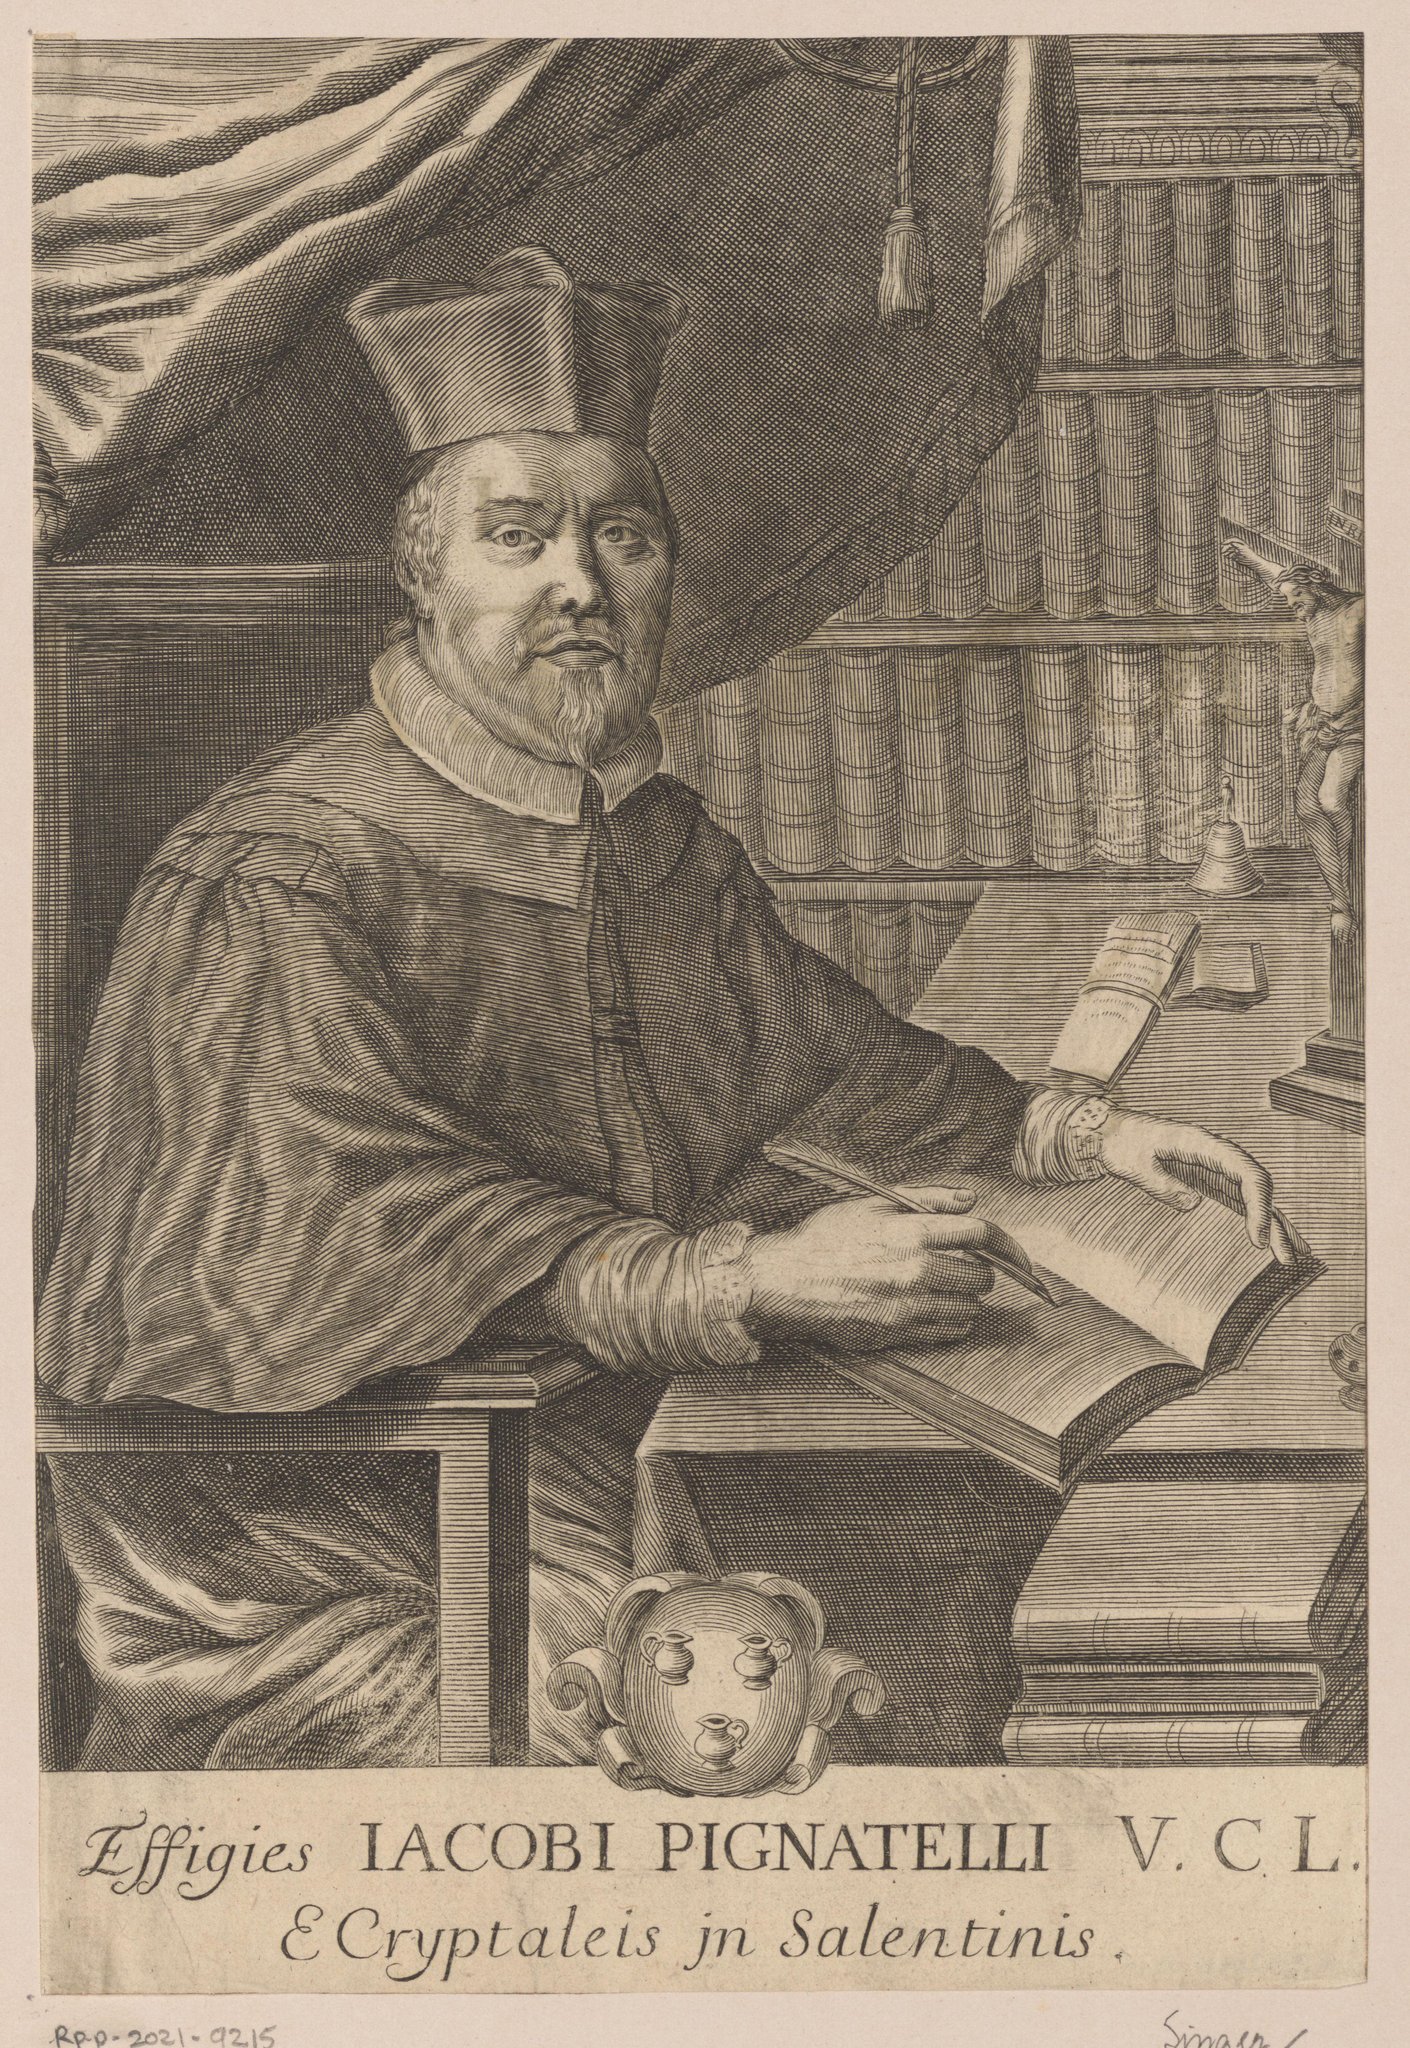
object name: book illustration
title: Portret van Jacob Pignatelli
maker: Anonymous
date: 1700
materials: paper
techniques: engraving, letterpress printing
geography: lyon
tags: adult man, historical persons, printed matter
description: Prent uit: Pignatelli, Jacobus. Consultationes canonicæ. Lyon: Gabrielis & Samuelis de Tournes, 1700, dl. 1.